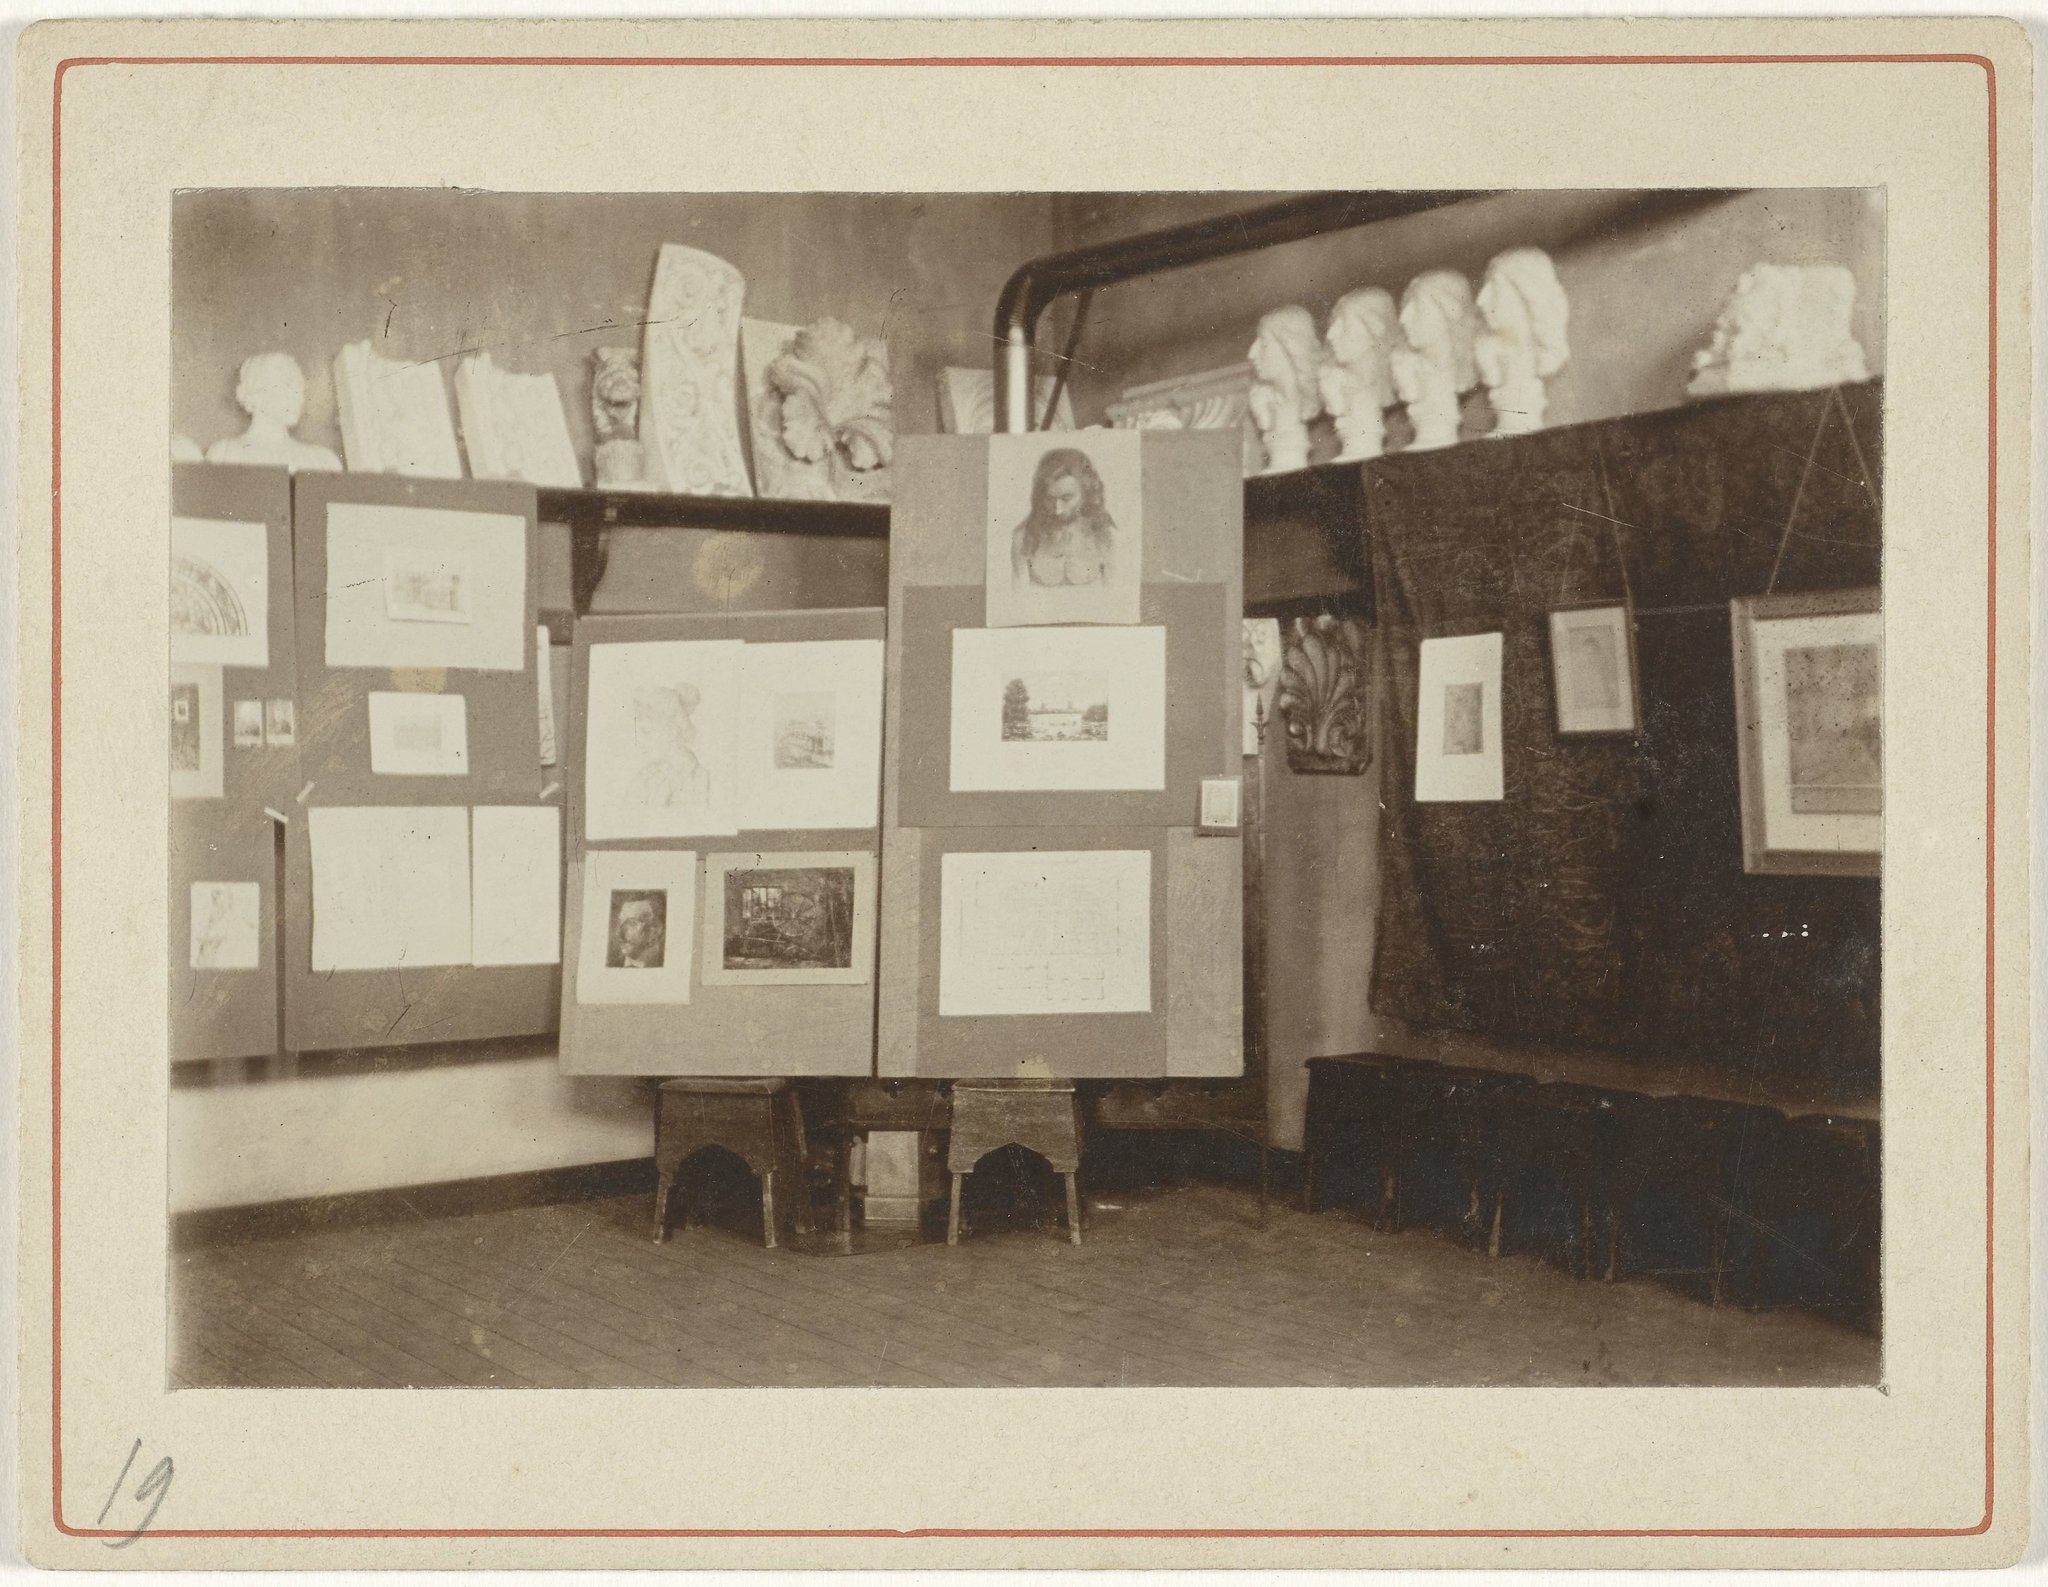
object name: photograph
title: Tentoonstelling met tekeningen en prenten van Willem Molkenboer, waarschijnlijk in de Rijksnormaalschool voor Teekenonderwijzers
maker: Anonymous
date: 1880-1910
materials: cardboard, paper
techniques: albumen print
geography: amsterdam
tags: wilhelmus bernardus gerardus molkenboer, interior ~ representation of a building, temporary exhibition, 'salon'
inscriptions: inscription: ‘Tent Molkenboer?’